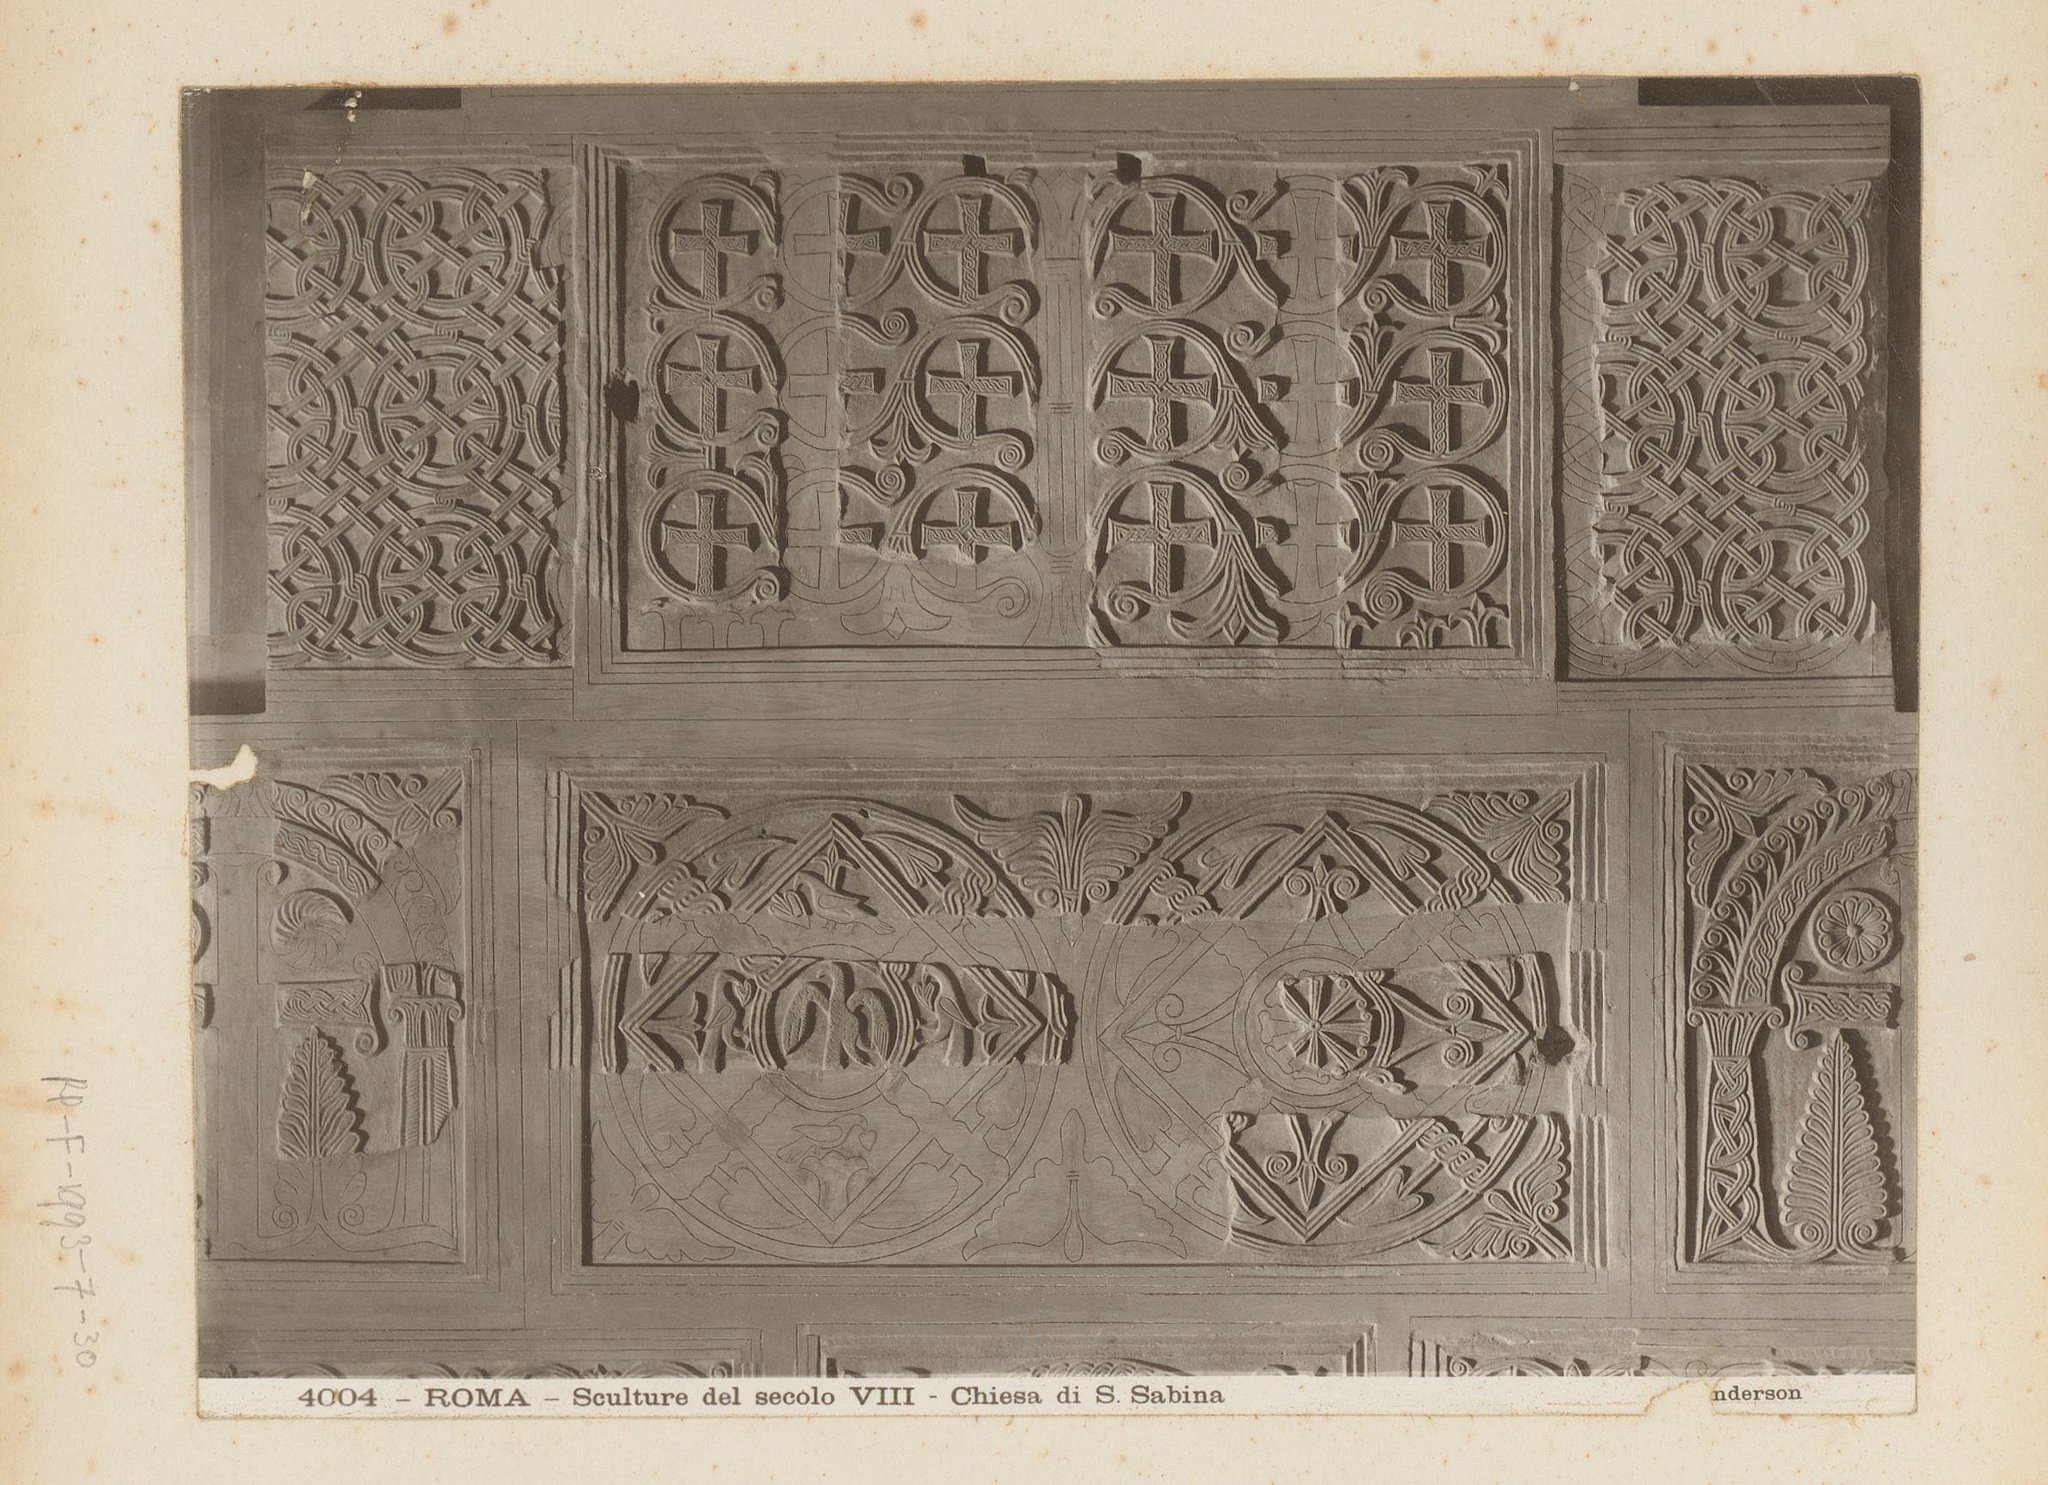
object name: album leaf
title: 4004 Roma Sculture del secolo VII - Chiesa di S. Sabina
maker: james anderson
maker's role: fotograaf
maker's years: 1813-1877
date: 1890-1925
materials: paper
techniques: gelatin silver print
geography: santa sabina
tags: ornaments ~ art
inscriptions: inscription: ‘4004 - ROMA - Sculture del secolo VIII - Chiesa di S. Sabina [A]nderson’